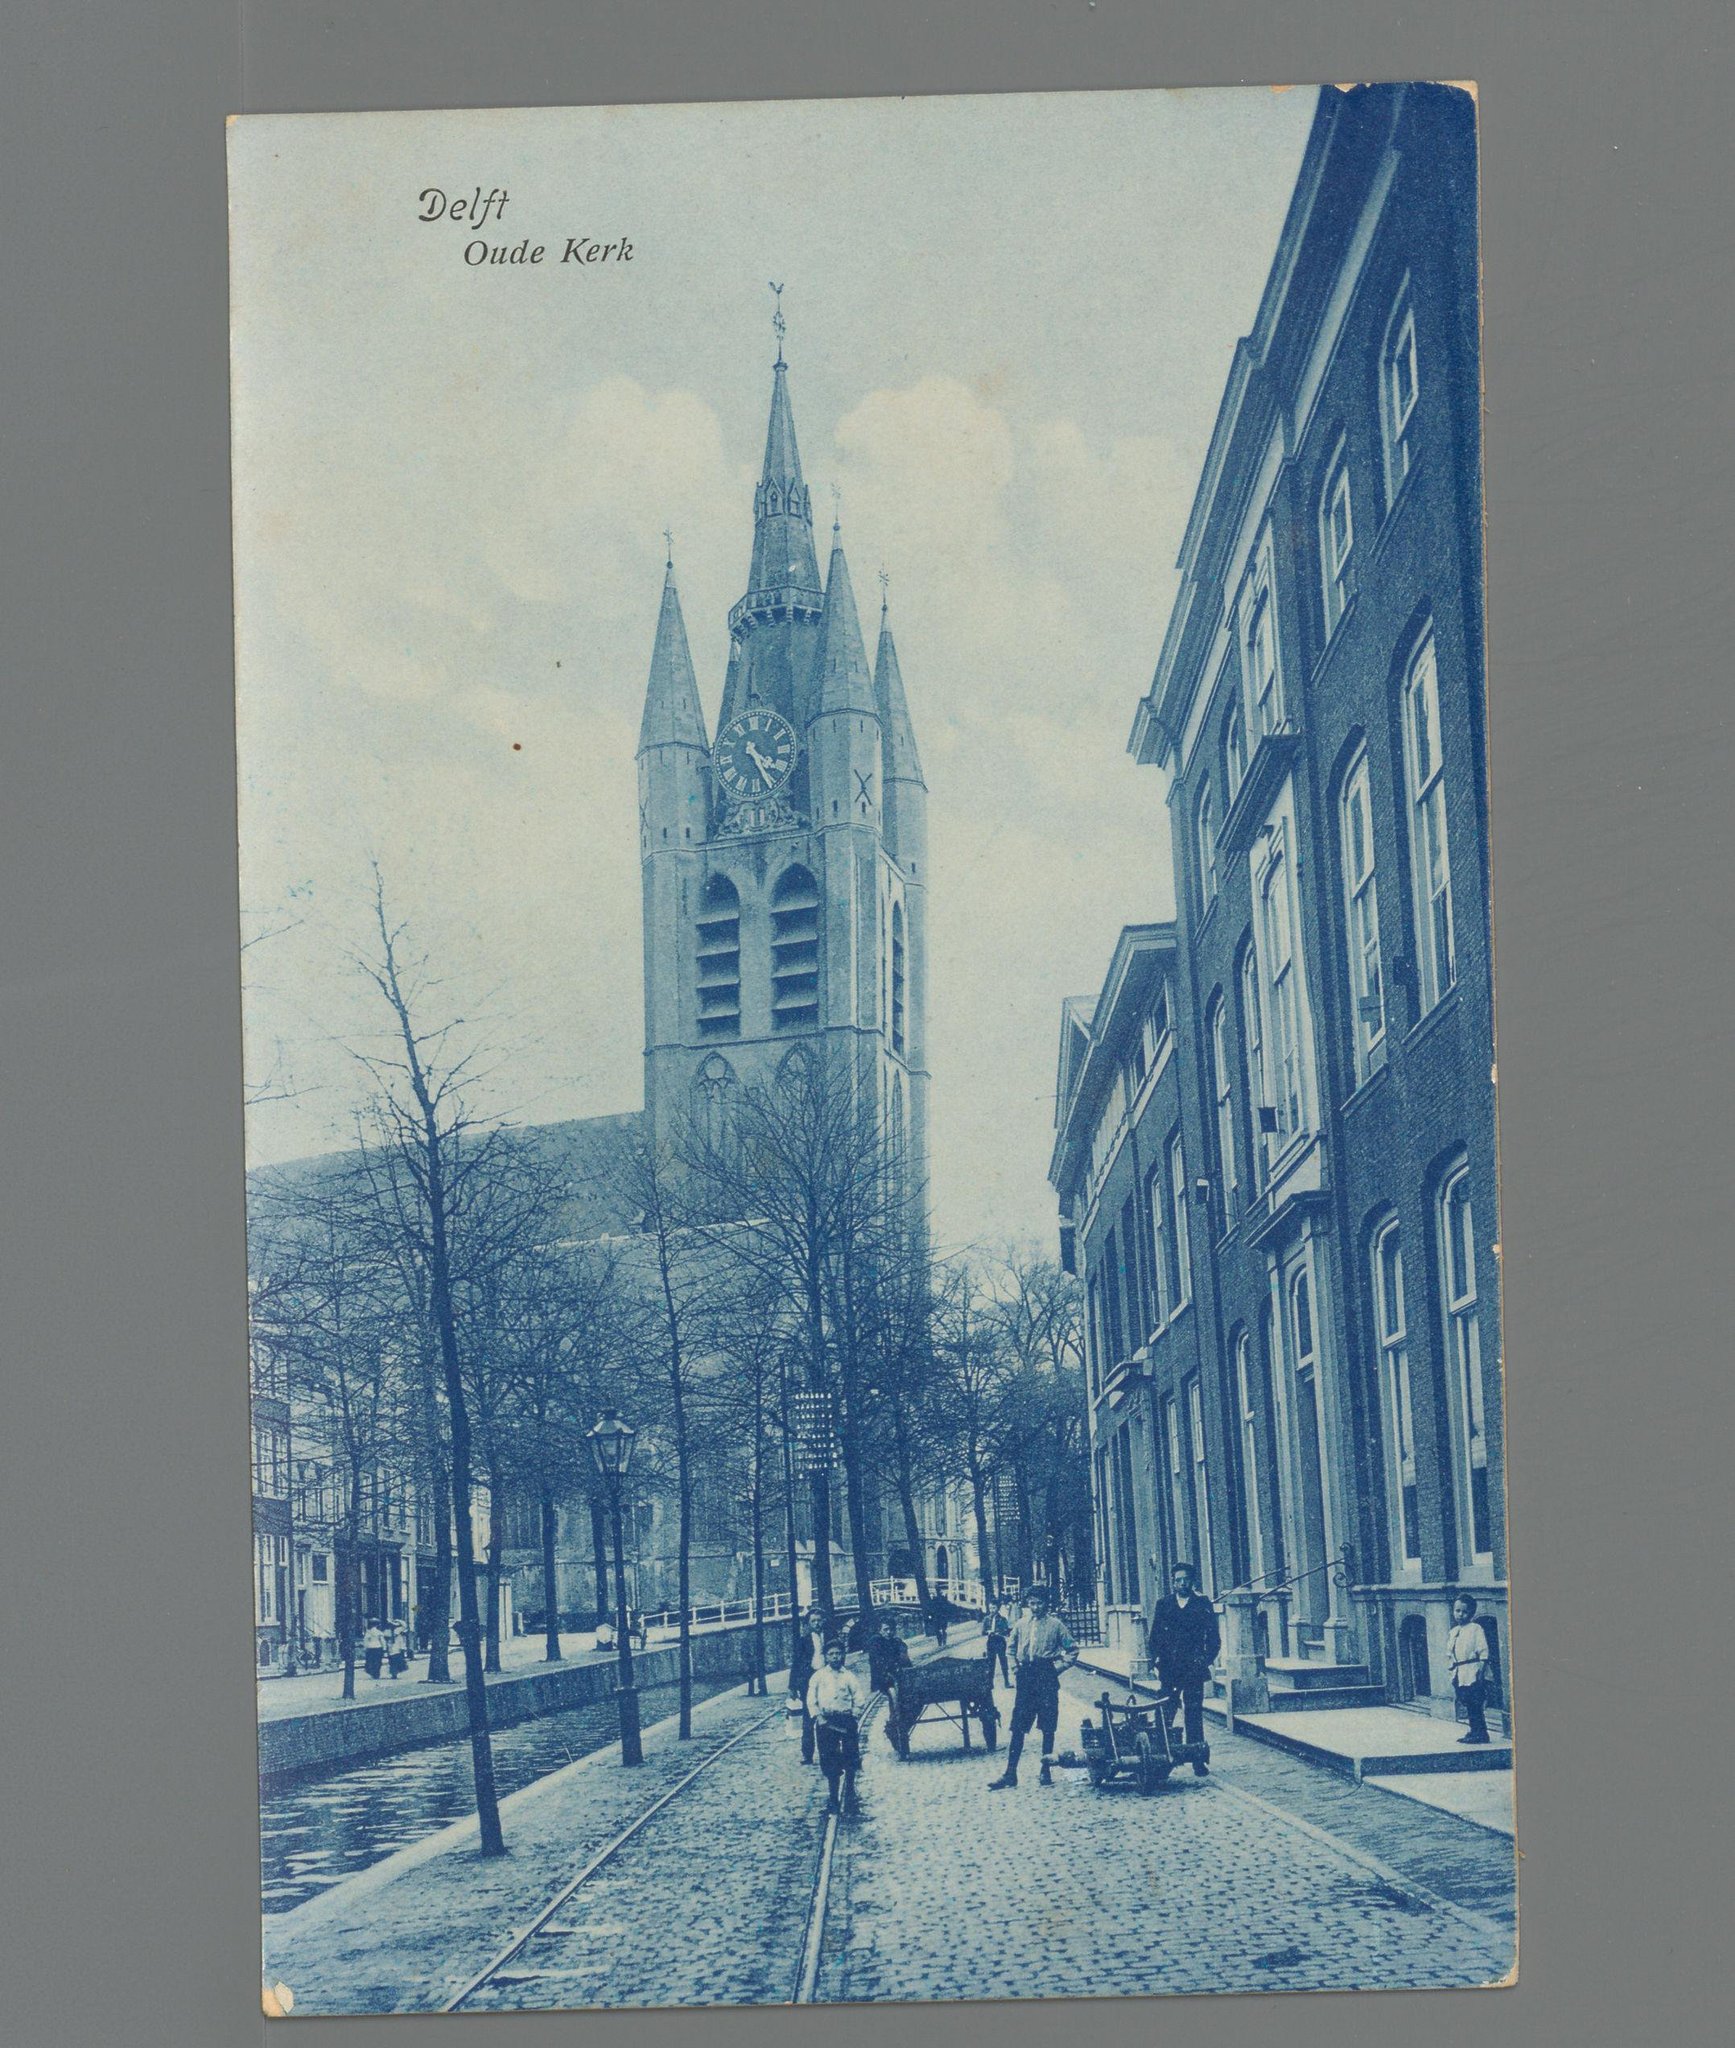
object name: photomechanical print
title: Delft. Oude Kerk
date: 1909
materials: cardboard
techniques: photograph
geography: delft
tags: canal, church (exterior), street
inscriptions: date